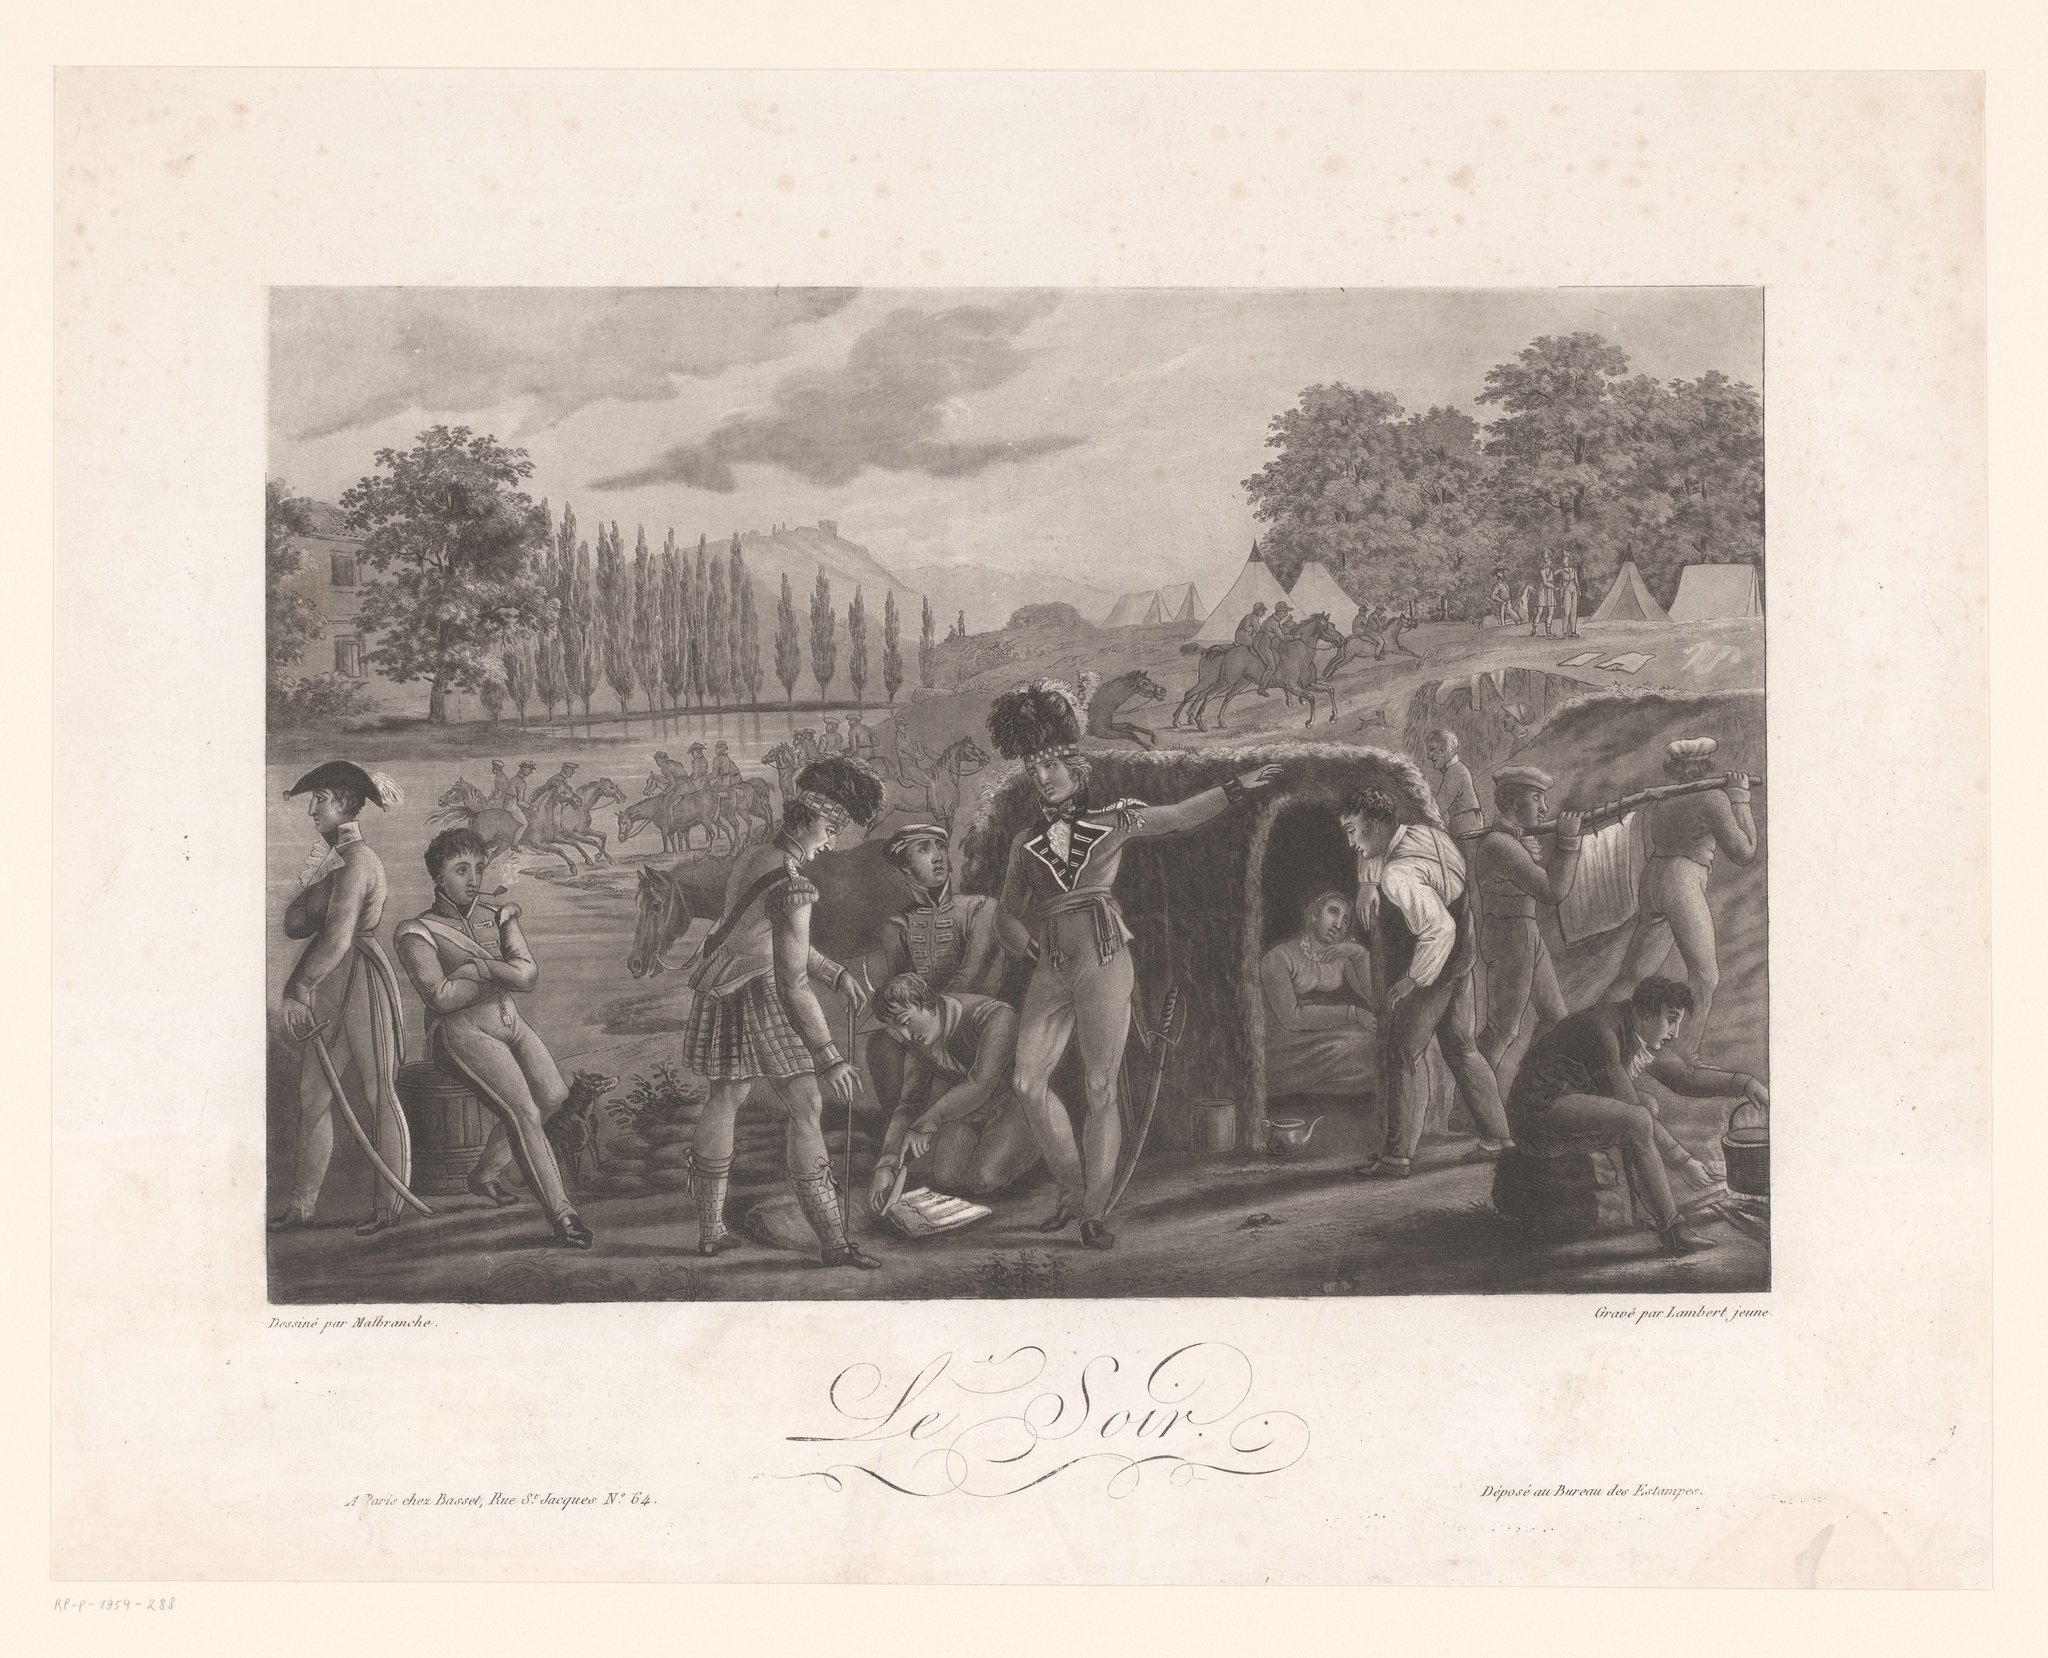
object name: print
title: Rustende militairen in een kamp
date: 1815-1841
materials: paper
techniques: aquatint, etching, roulette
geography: paris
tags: (military) camp with tents, evening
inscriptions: collector's mark: Lugt 2228, : ‘Déposé au Bureau des Estampes’